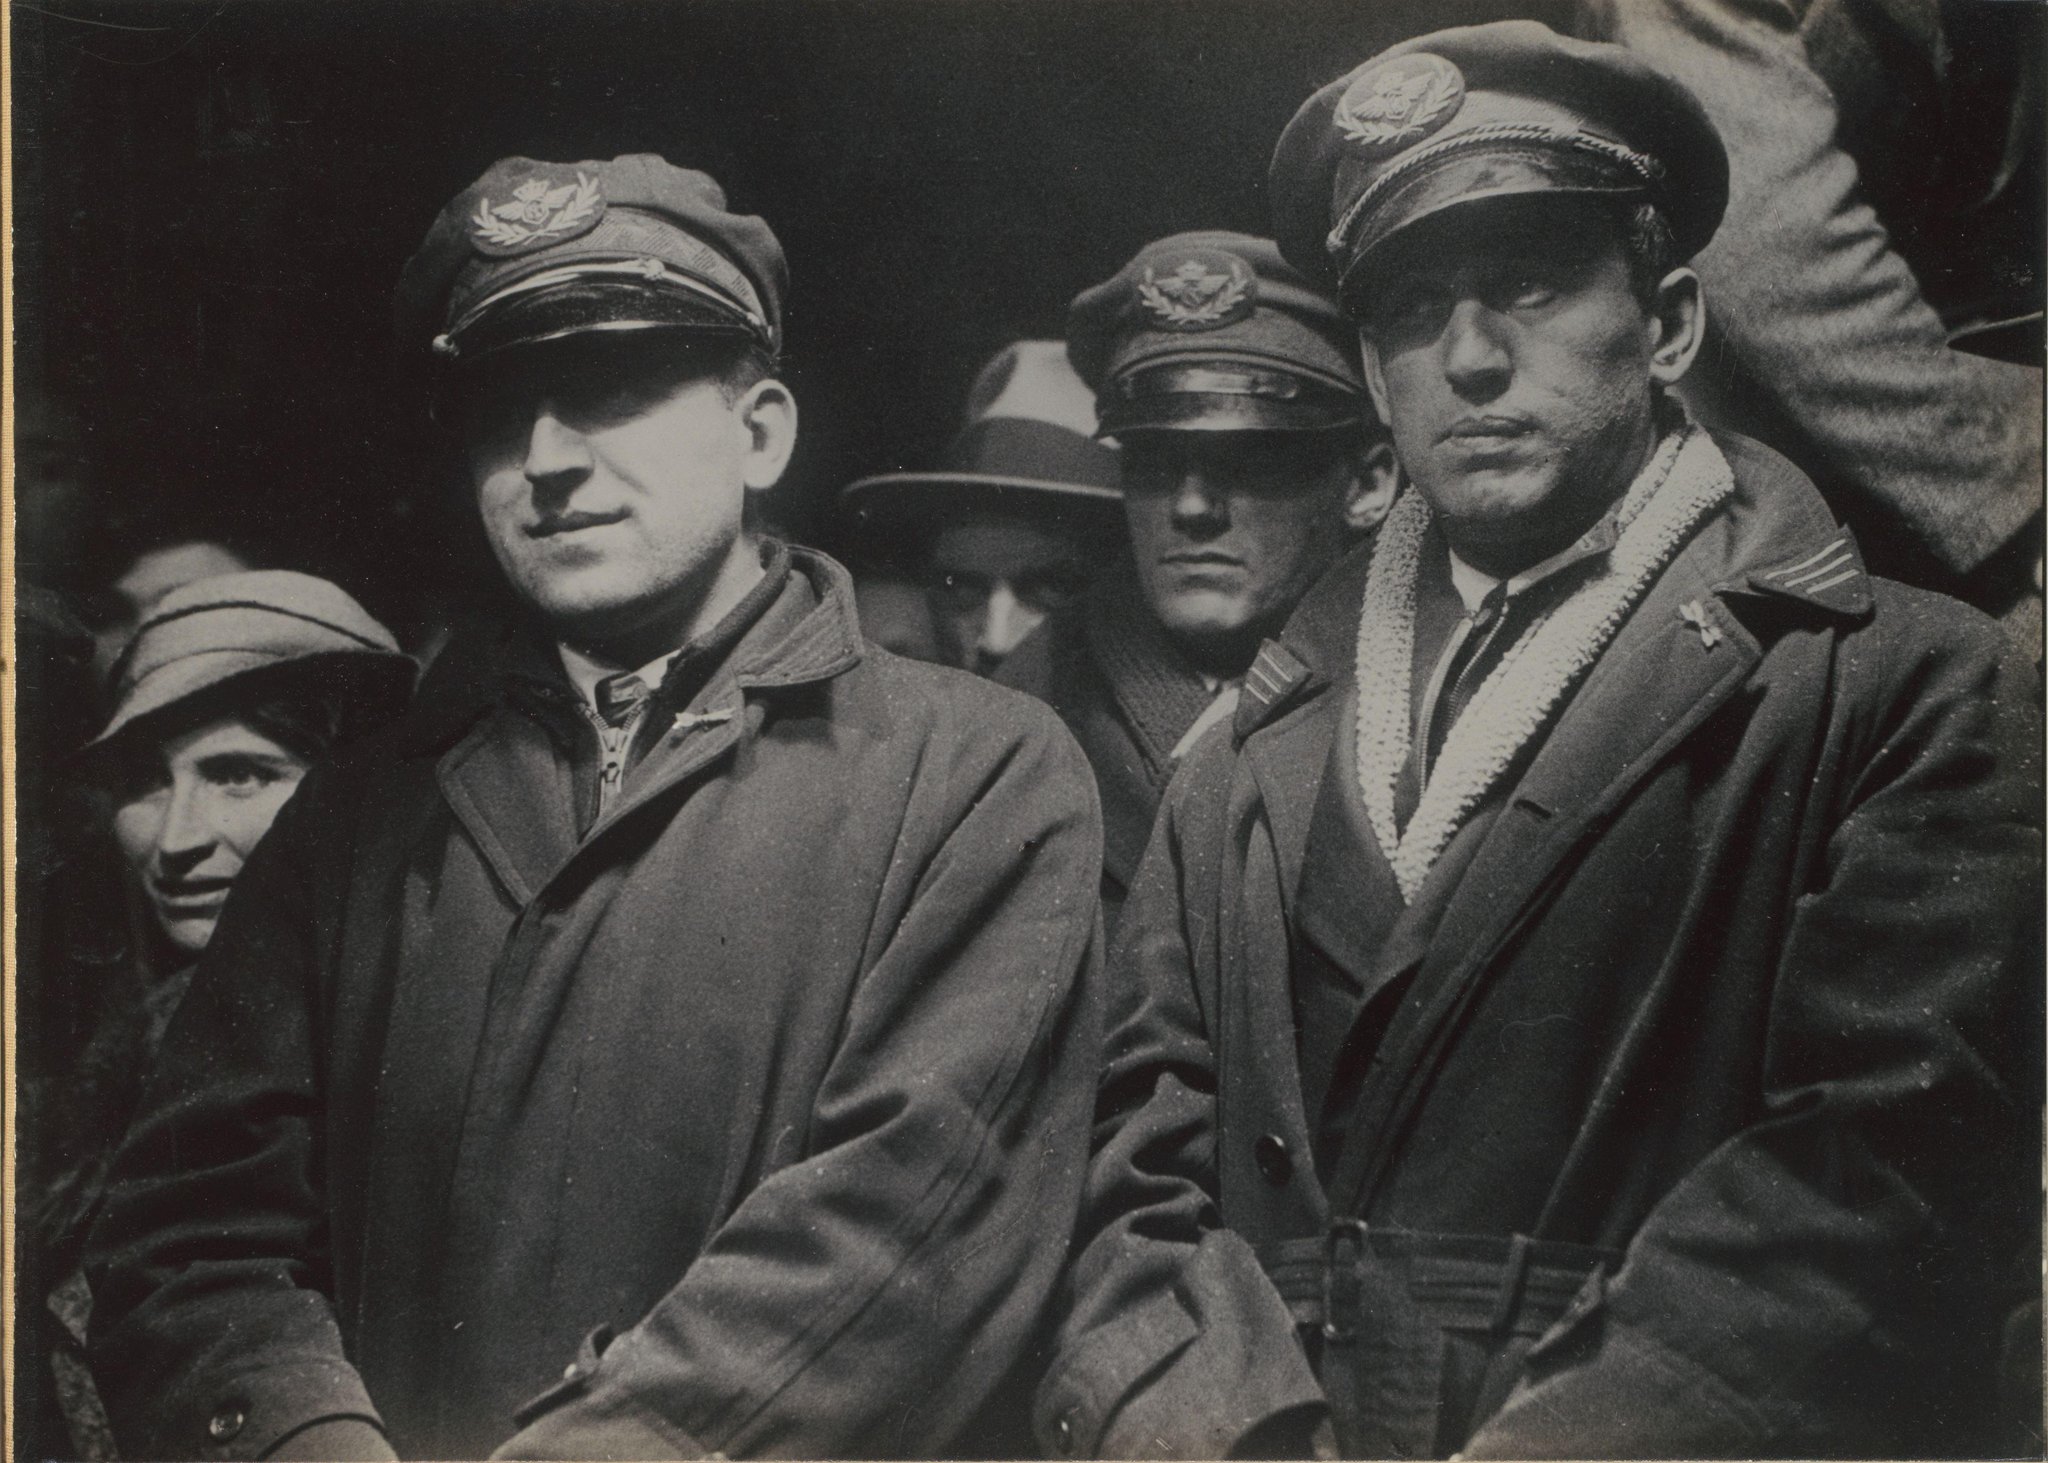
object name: photograph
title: KLM-bemanningsleden van de 'Pelikaan'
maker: Anonymous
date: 1933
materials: cardboard, paper, photographic support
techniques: gelatin silver print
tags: airborne traffic, aviation, pilot, flight crew, travelling; tourism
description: Albumblad met een foto van drie bemanningsleden van de 'Pelikaan', het KLM-toestel dat in december 1933 in een recordtijd van vier dagen Kerst- en nieuwjaarspost van Amsterdam naar Batavia bracht. Onderdeel van Herdenkingsalbum van de Indië-lijn van de KLM, deel I.